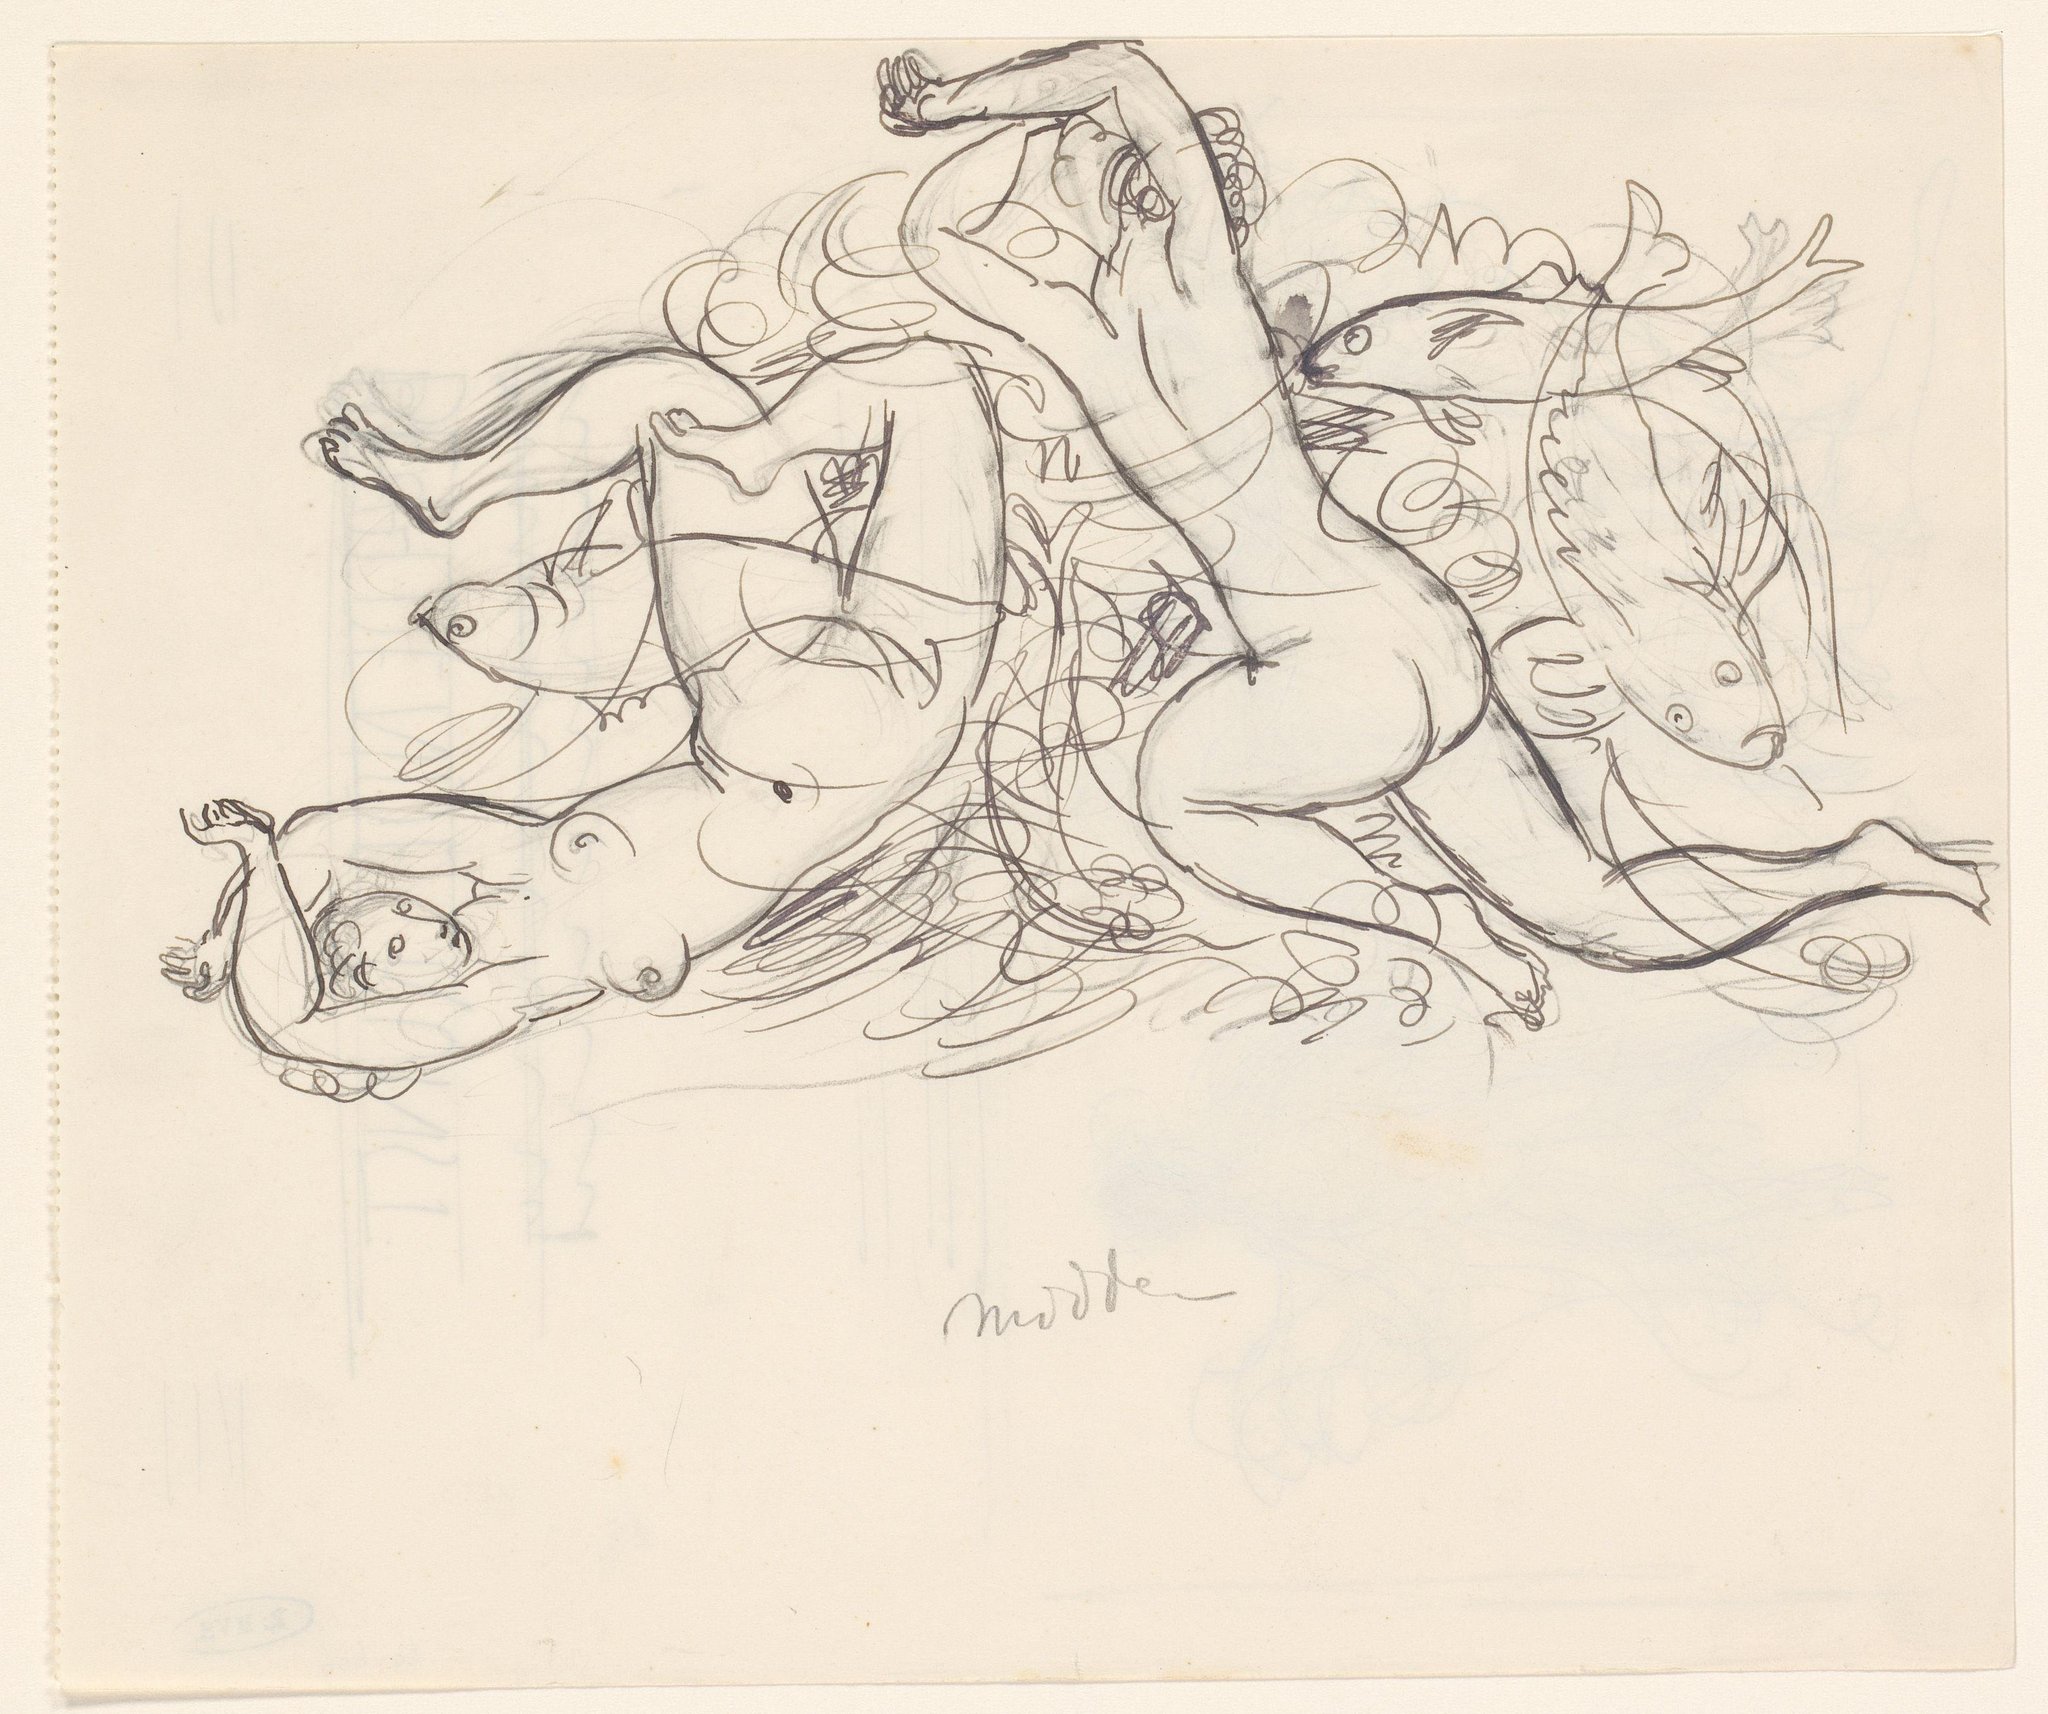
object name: drawing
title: Twee naakte vrouwen en drie vissen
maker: leo gestel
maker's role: draughtsman, print maker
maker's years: 1881-1941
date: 1891-1941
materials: ink, paper, pencil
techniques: pen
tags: swimming (movement in water) - aa - female human figure (+ nude human being), fishes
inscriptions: clichéaanwijzing, onder, handgeschreven